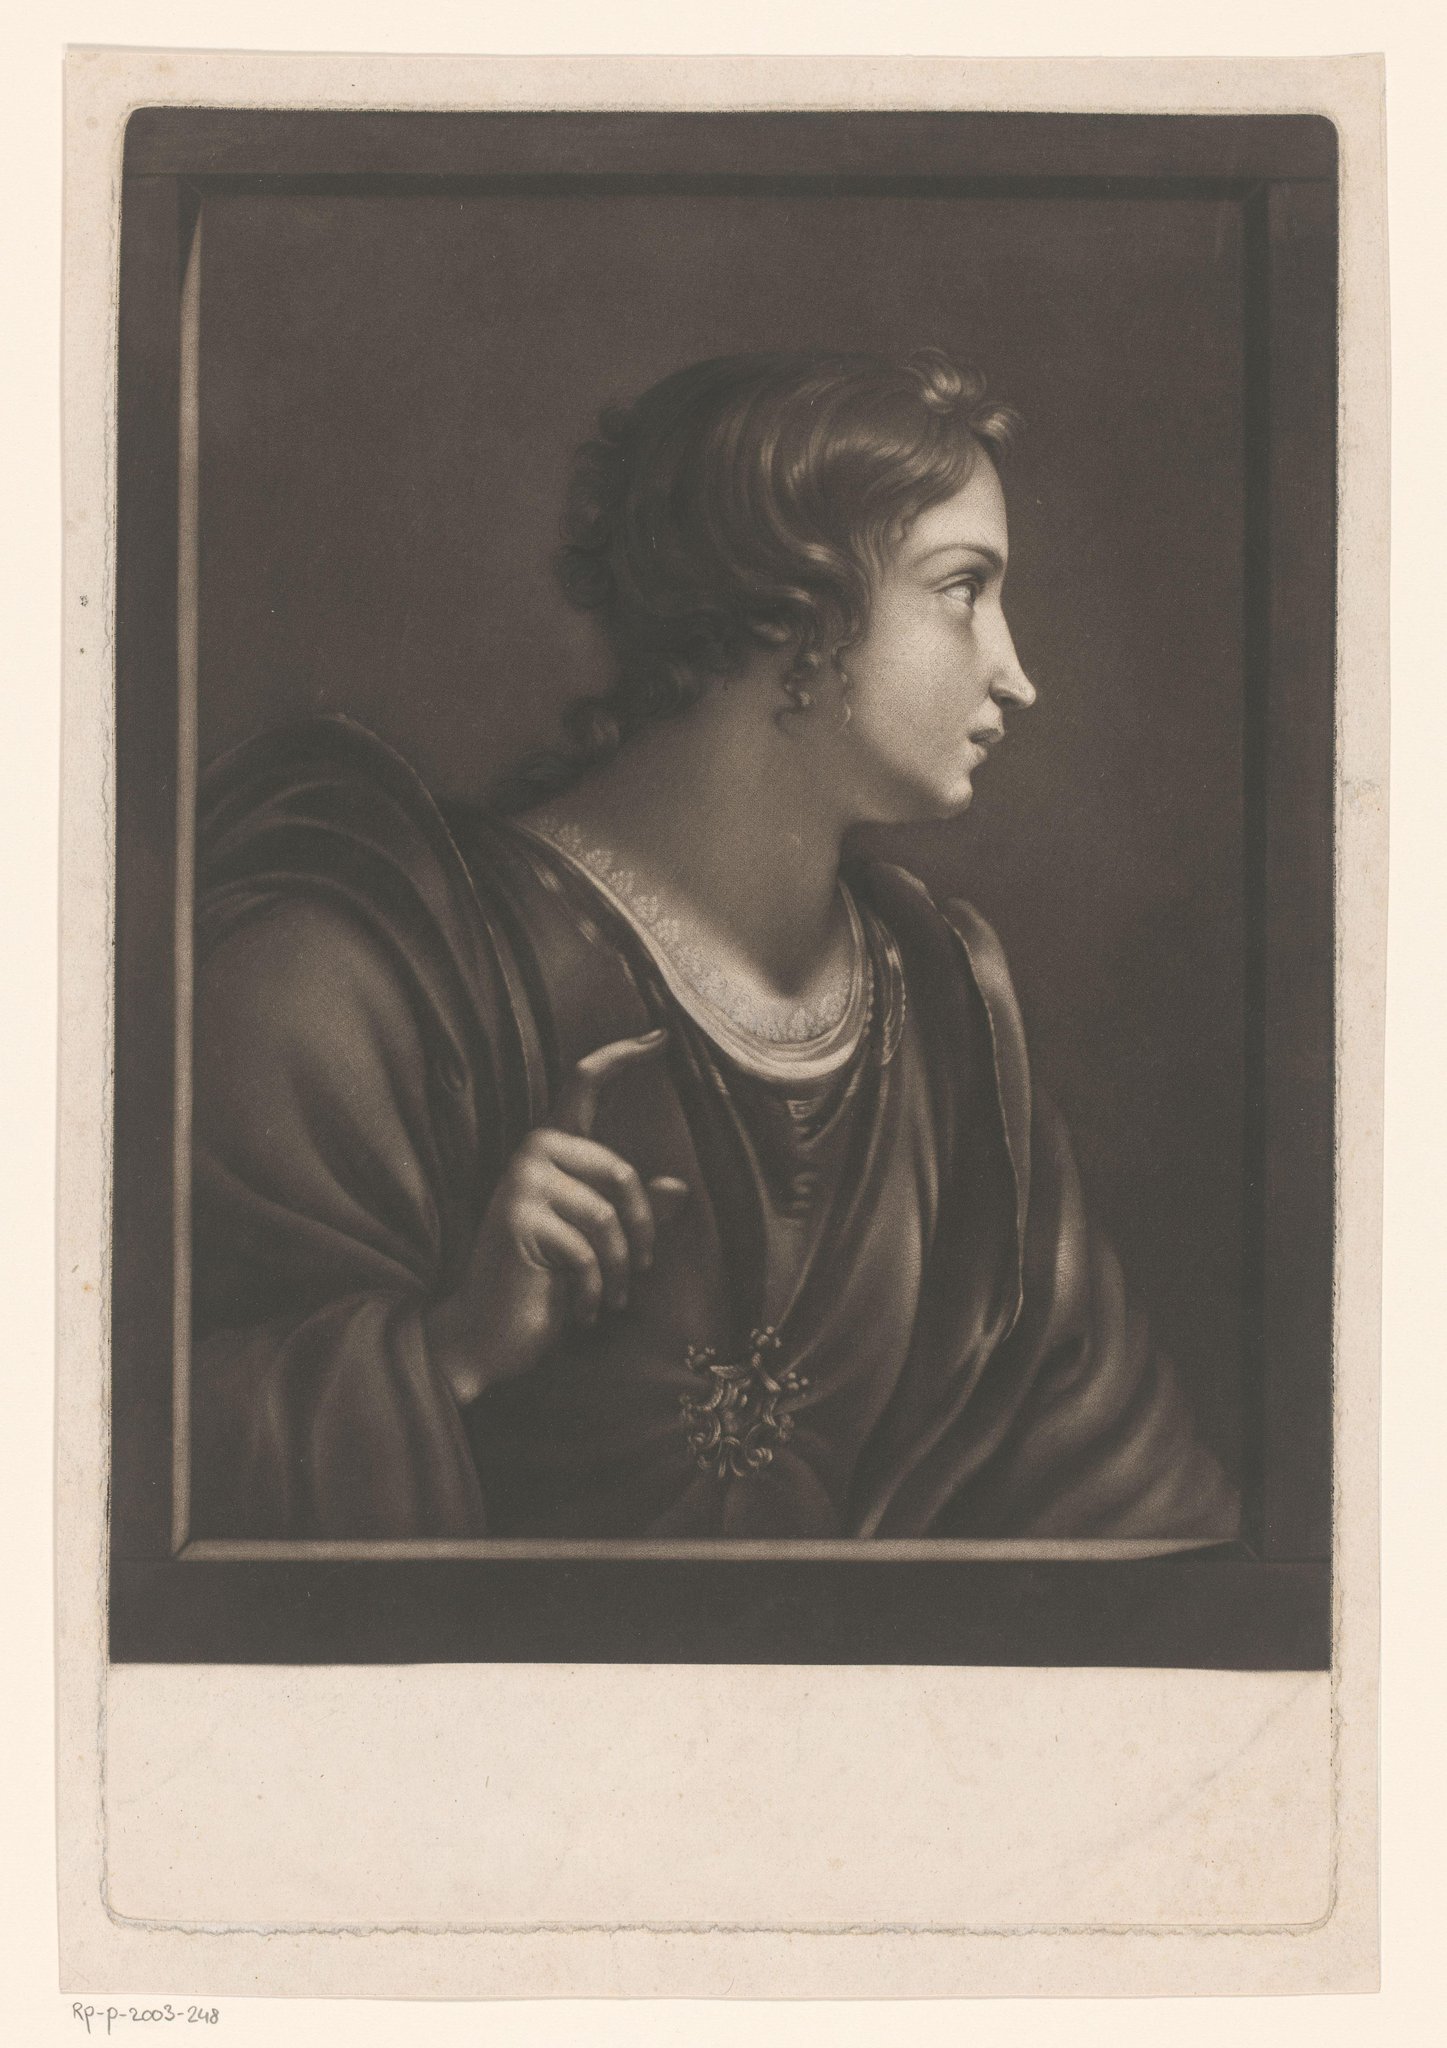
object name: print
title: Maria Magdalena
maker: johann elias haid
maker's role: print maker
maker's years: 1739-1809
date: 1749-1809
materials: paper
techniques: mezzotint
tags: the penitent harlot mary magdalene; possible attributes: book (or scroll), crown, crown of thorns, crucifix, jar of ointment, mirror, musical instrument, palm-branch, rosary, scourge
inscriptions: collector's mark: Lugt 2228